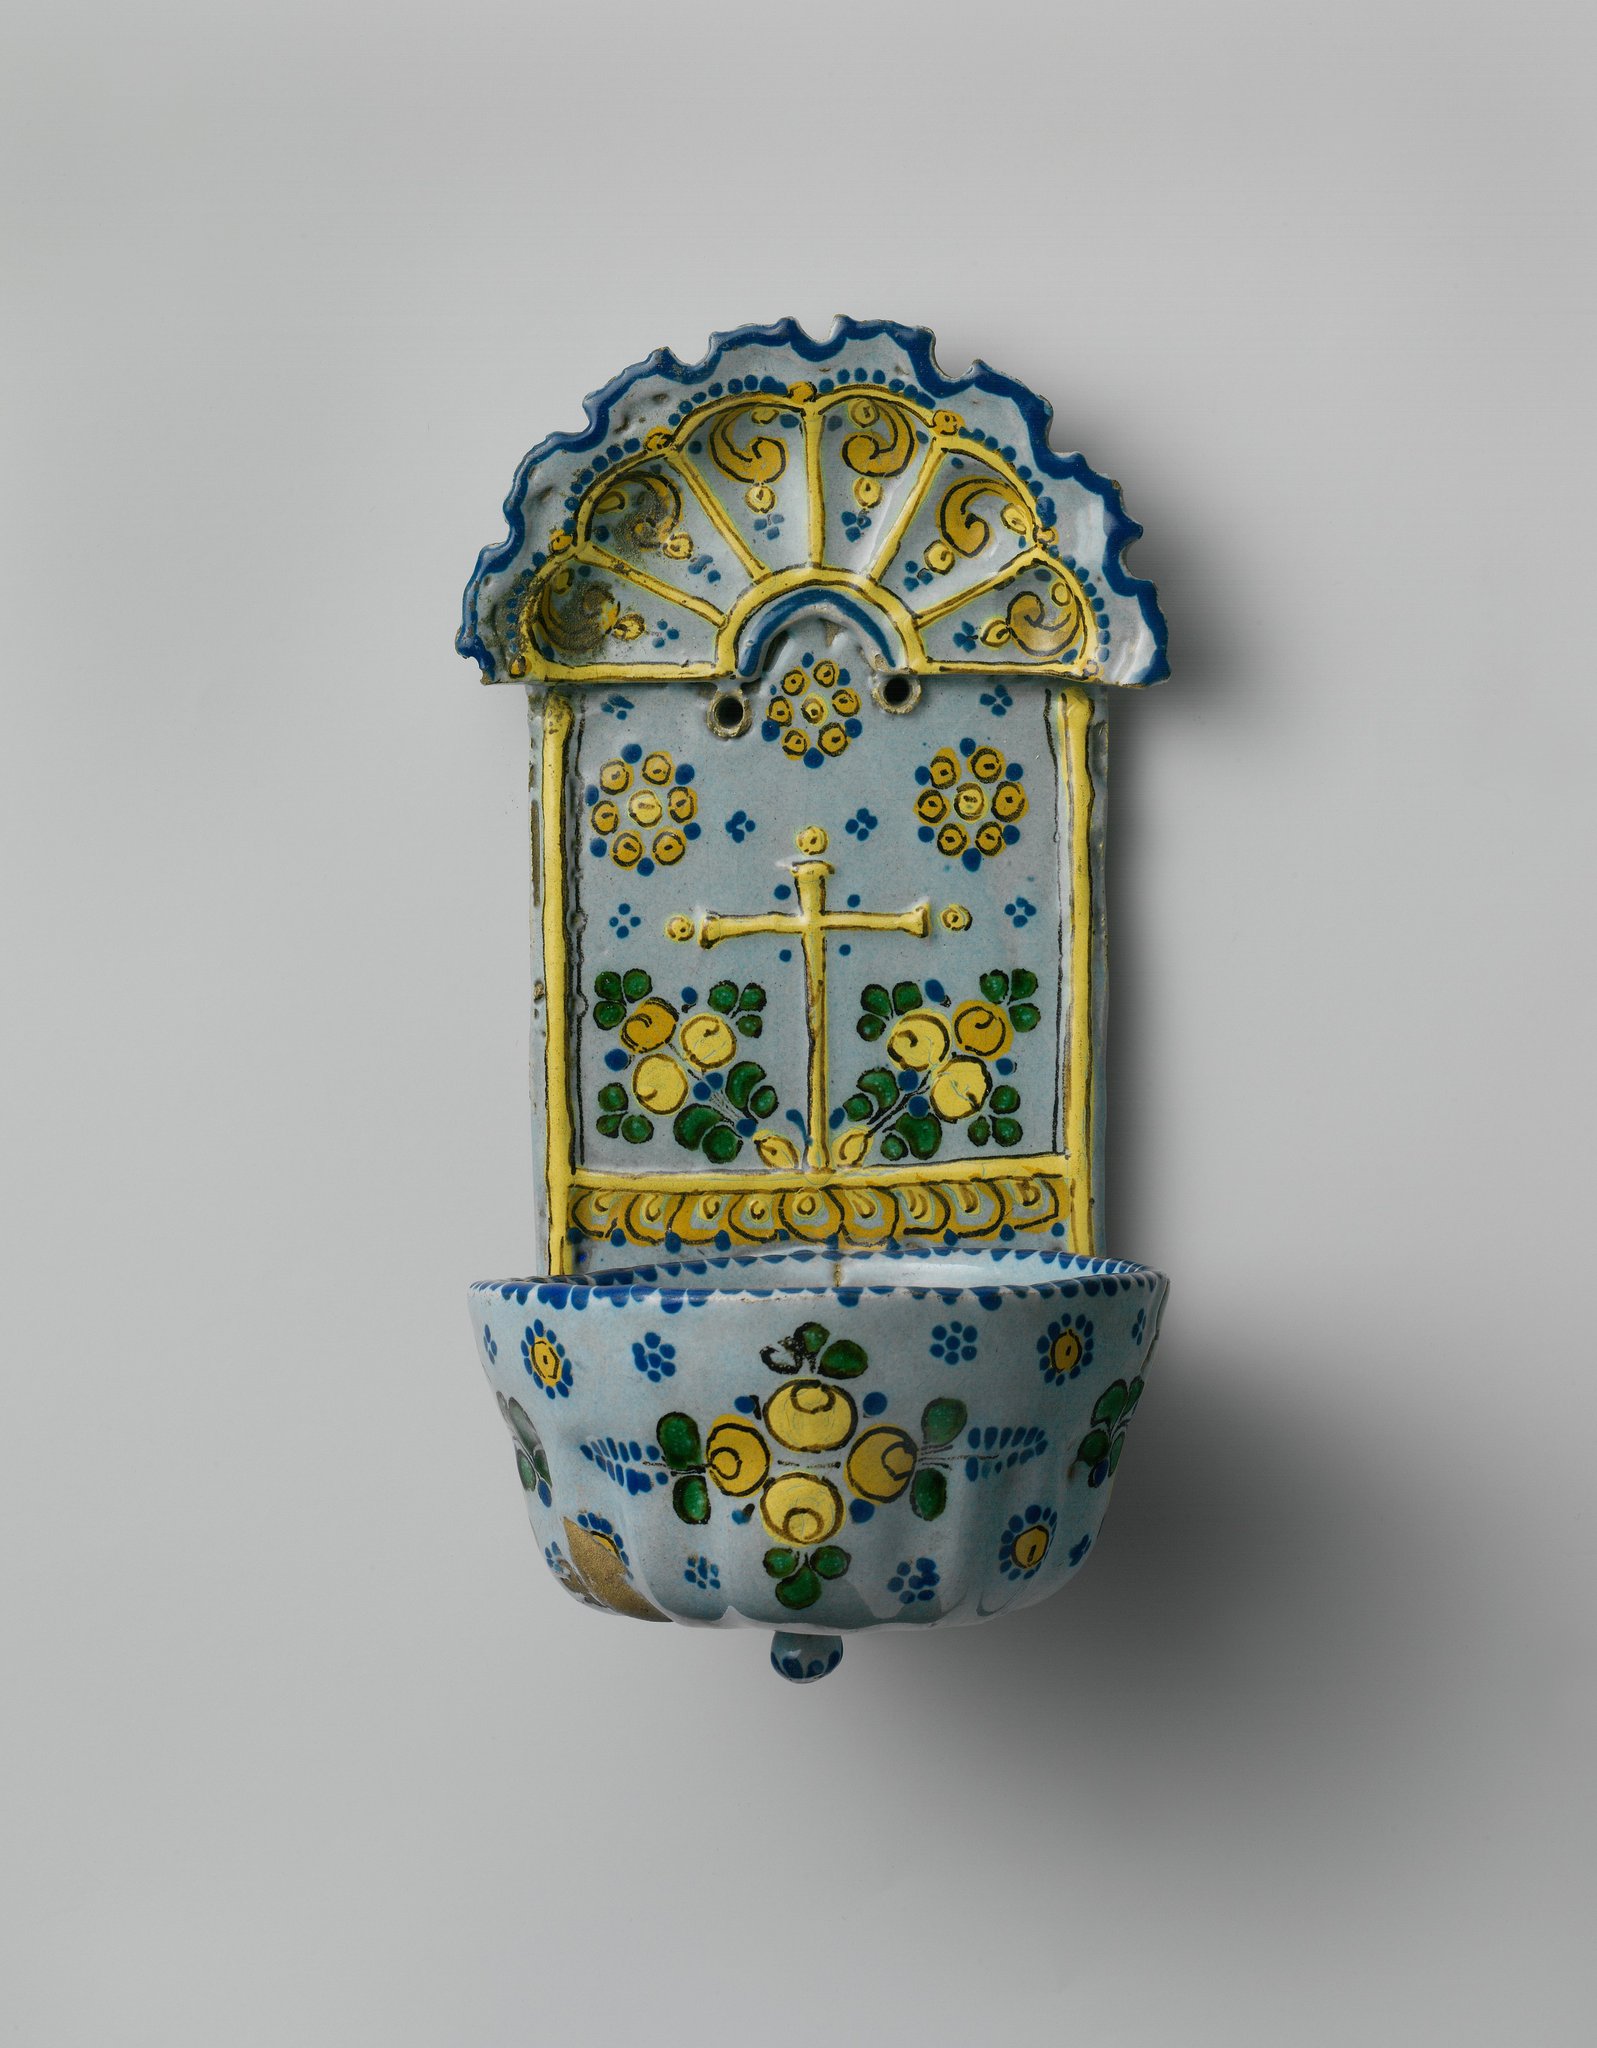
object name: holy water basin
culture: mexican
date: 1820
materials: earthenware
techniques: glazing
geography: mexico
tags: cross,baptismal fonts